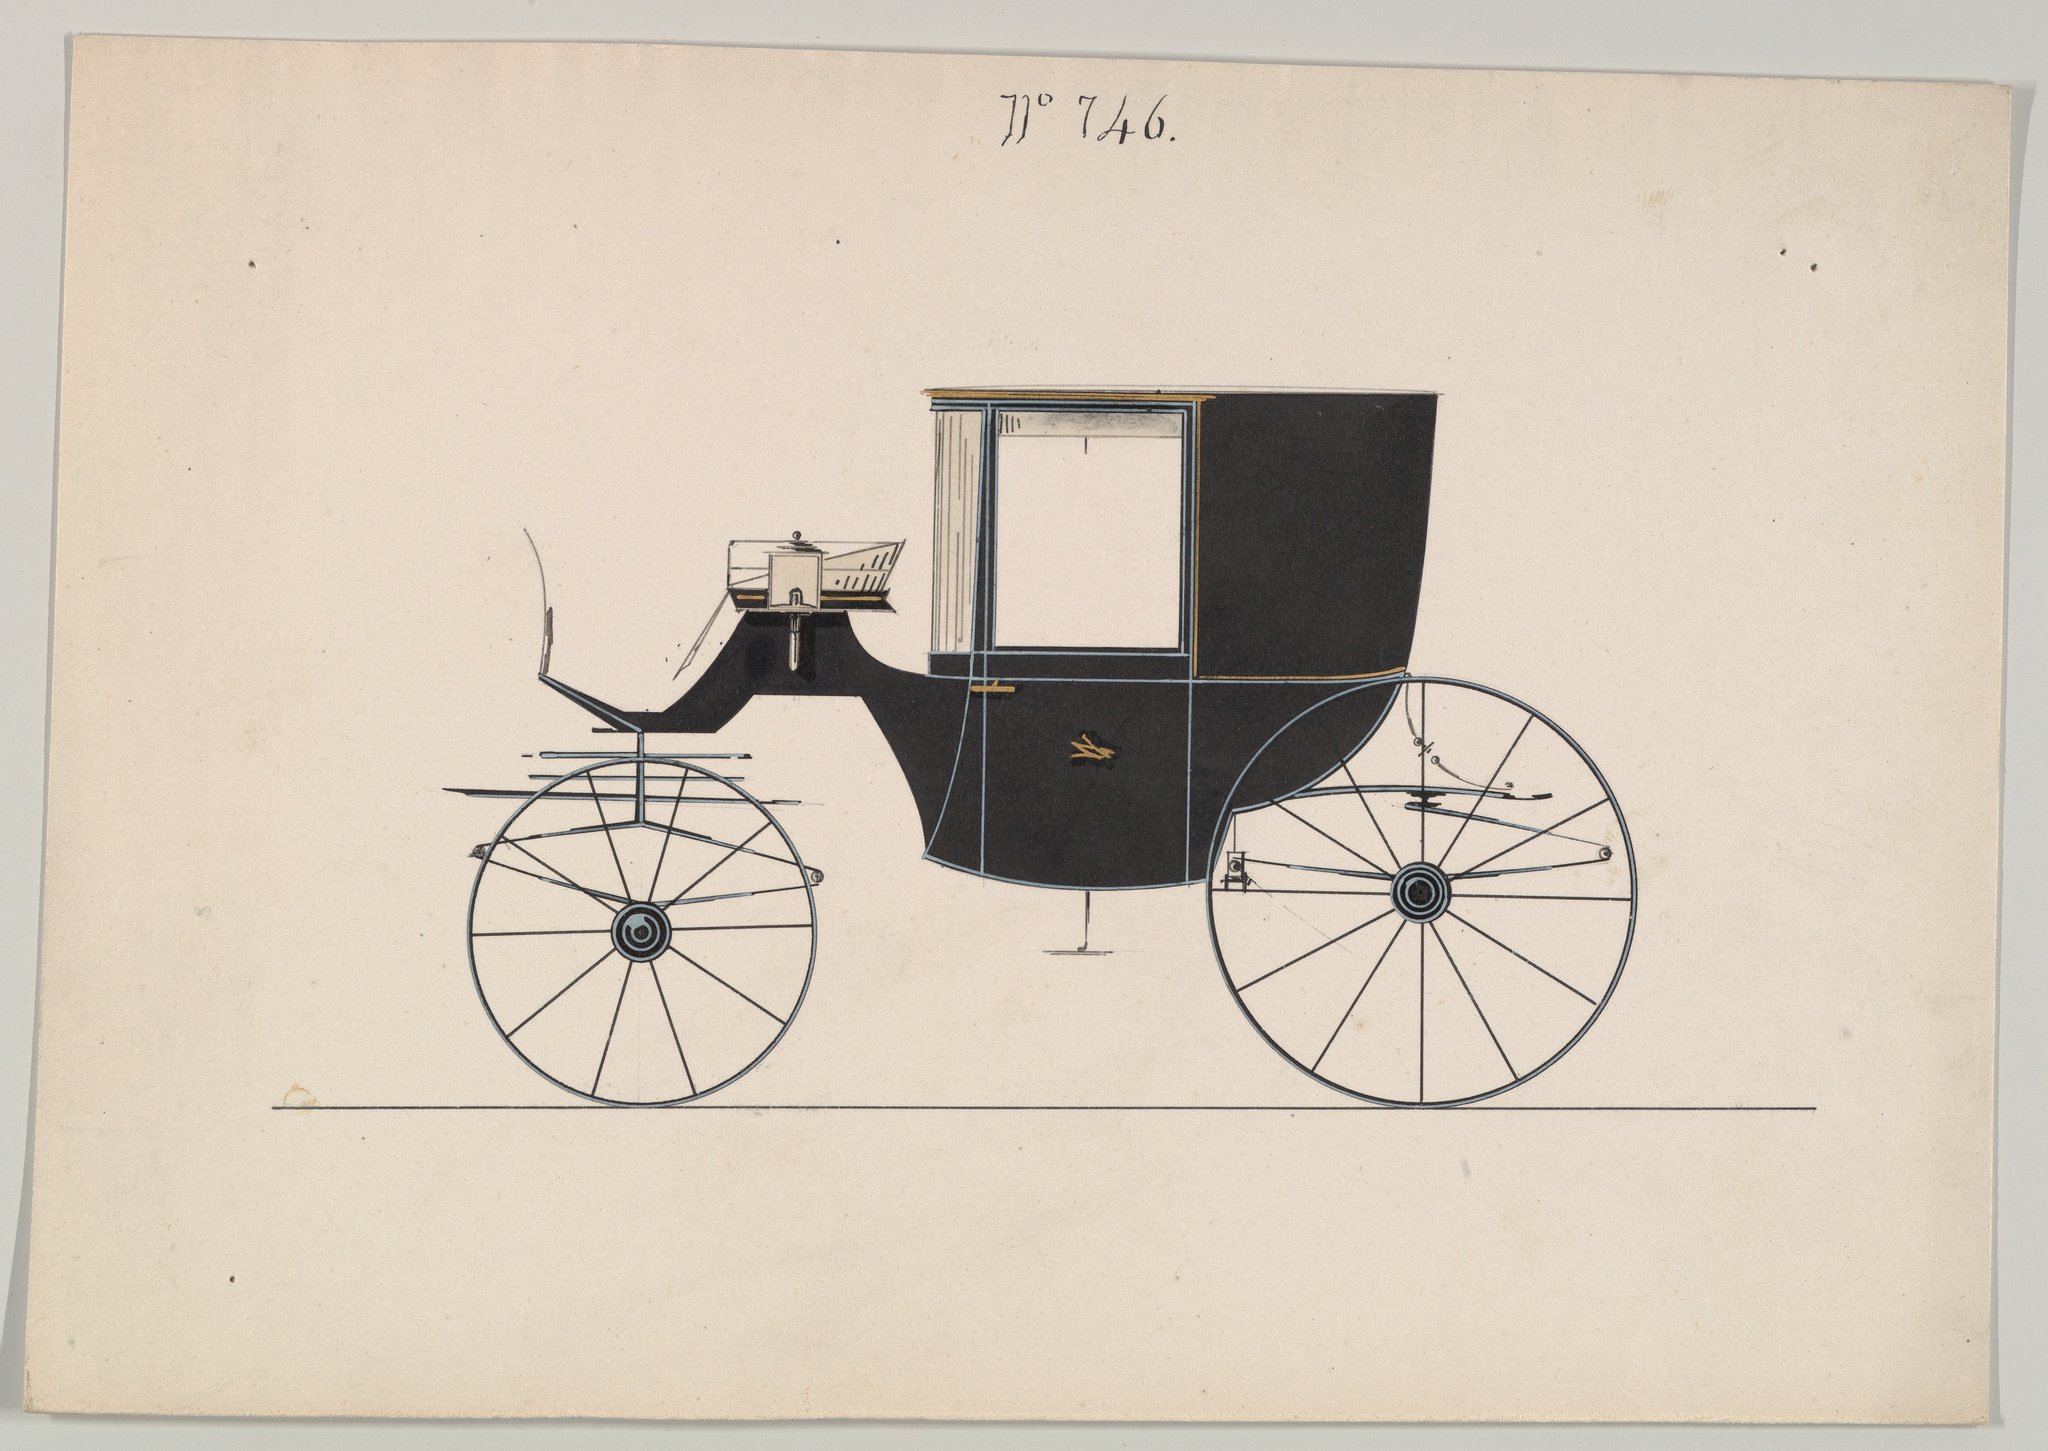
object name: drawing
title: Coupé # 746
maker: brewster & co.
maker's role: manufacturer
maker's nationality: american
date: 1850-1870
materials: gouache, ink, watercolor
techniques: pen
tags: carriages